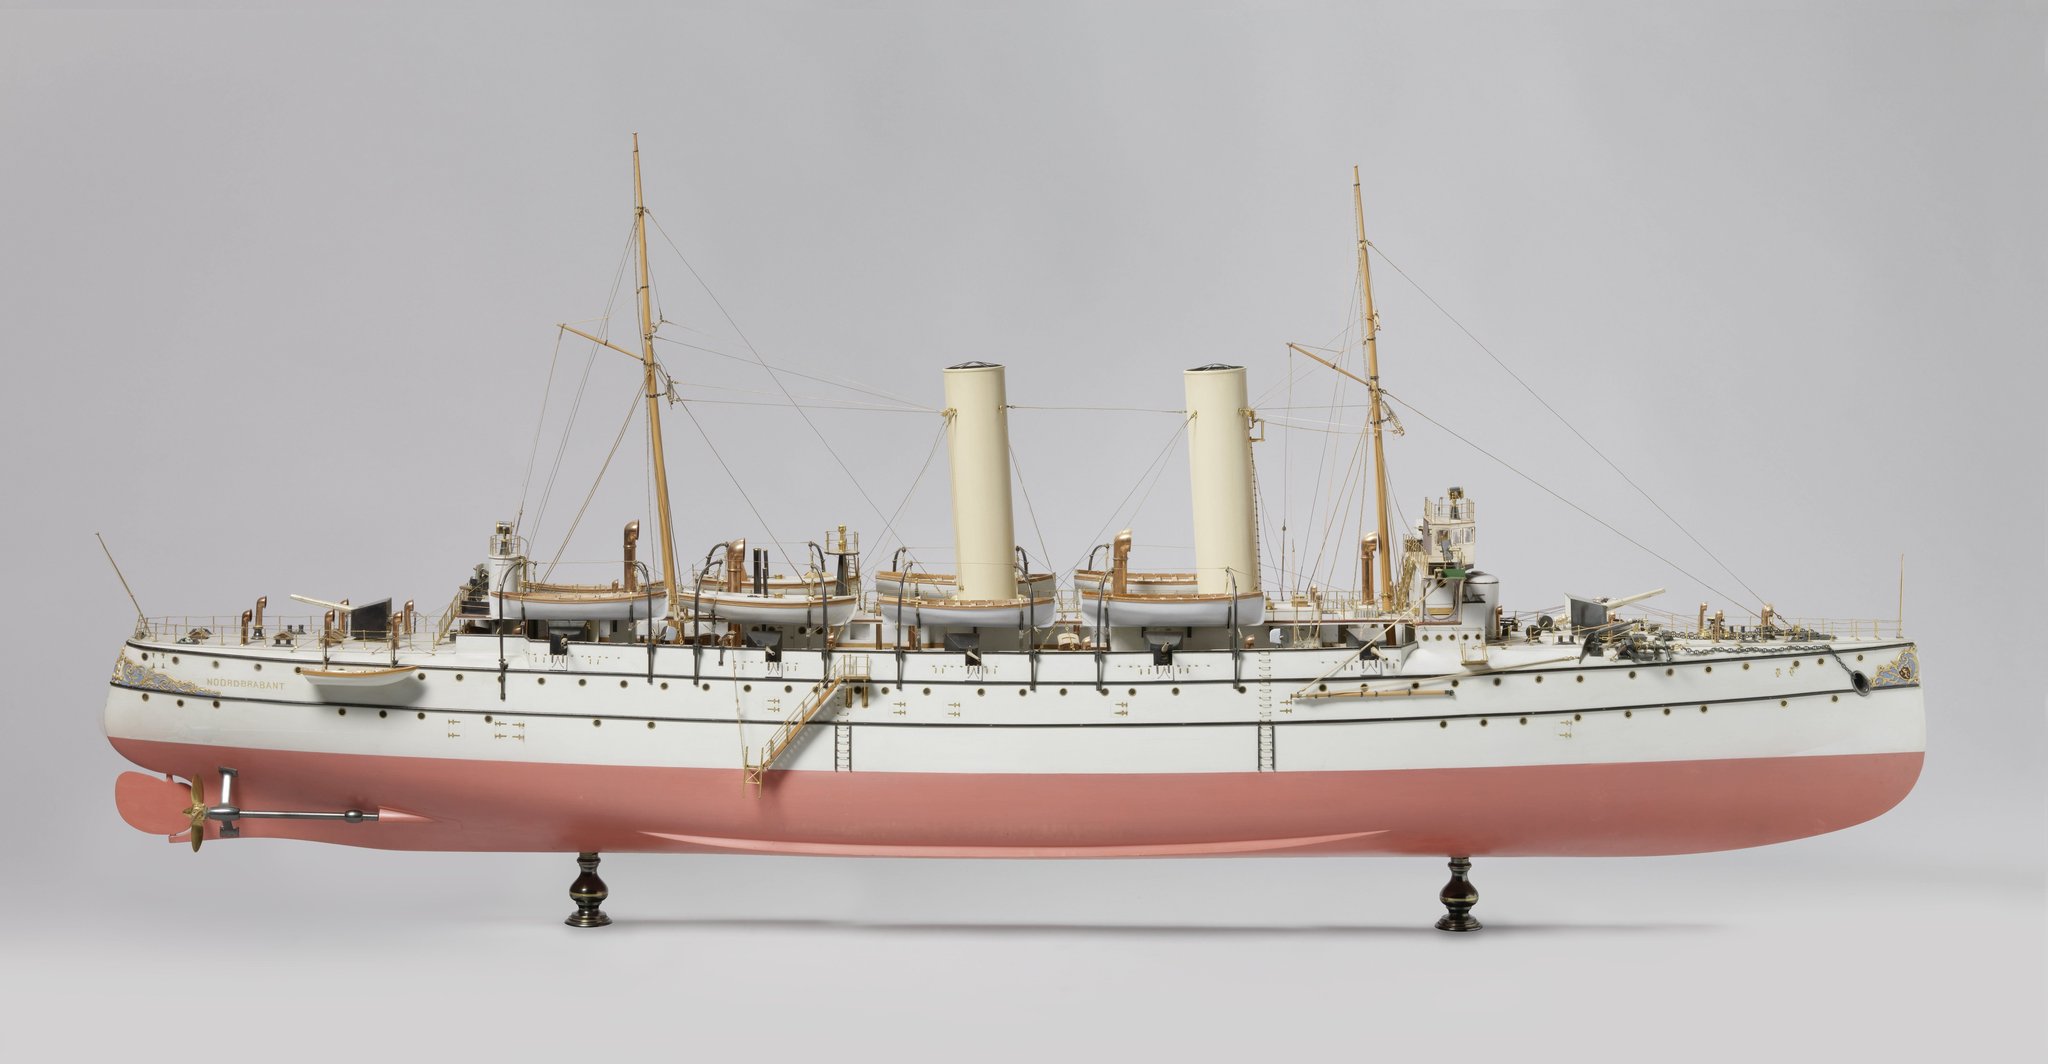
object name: ship model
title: Model of a Protected Cruiser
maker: Anonymous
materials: brass, fiber, wood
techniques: polychromy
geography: netherlands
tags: ship-model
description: Protected cruisers are armoured down to the waterline, shielding against bullets and grenades. Noord-Brabant, the fifth in a series of six protected cruisers, entered the Dutch fleet in 1900. Its construction was based on that of the British cruiser Apollo. Developments in armoured protection of warships by other countries were closely followed by the Royal Netherlands Navy.